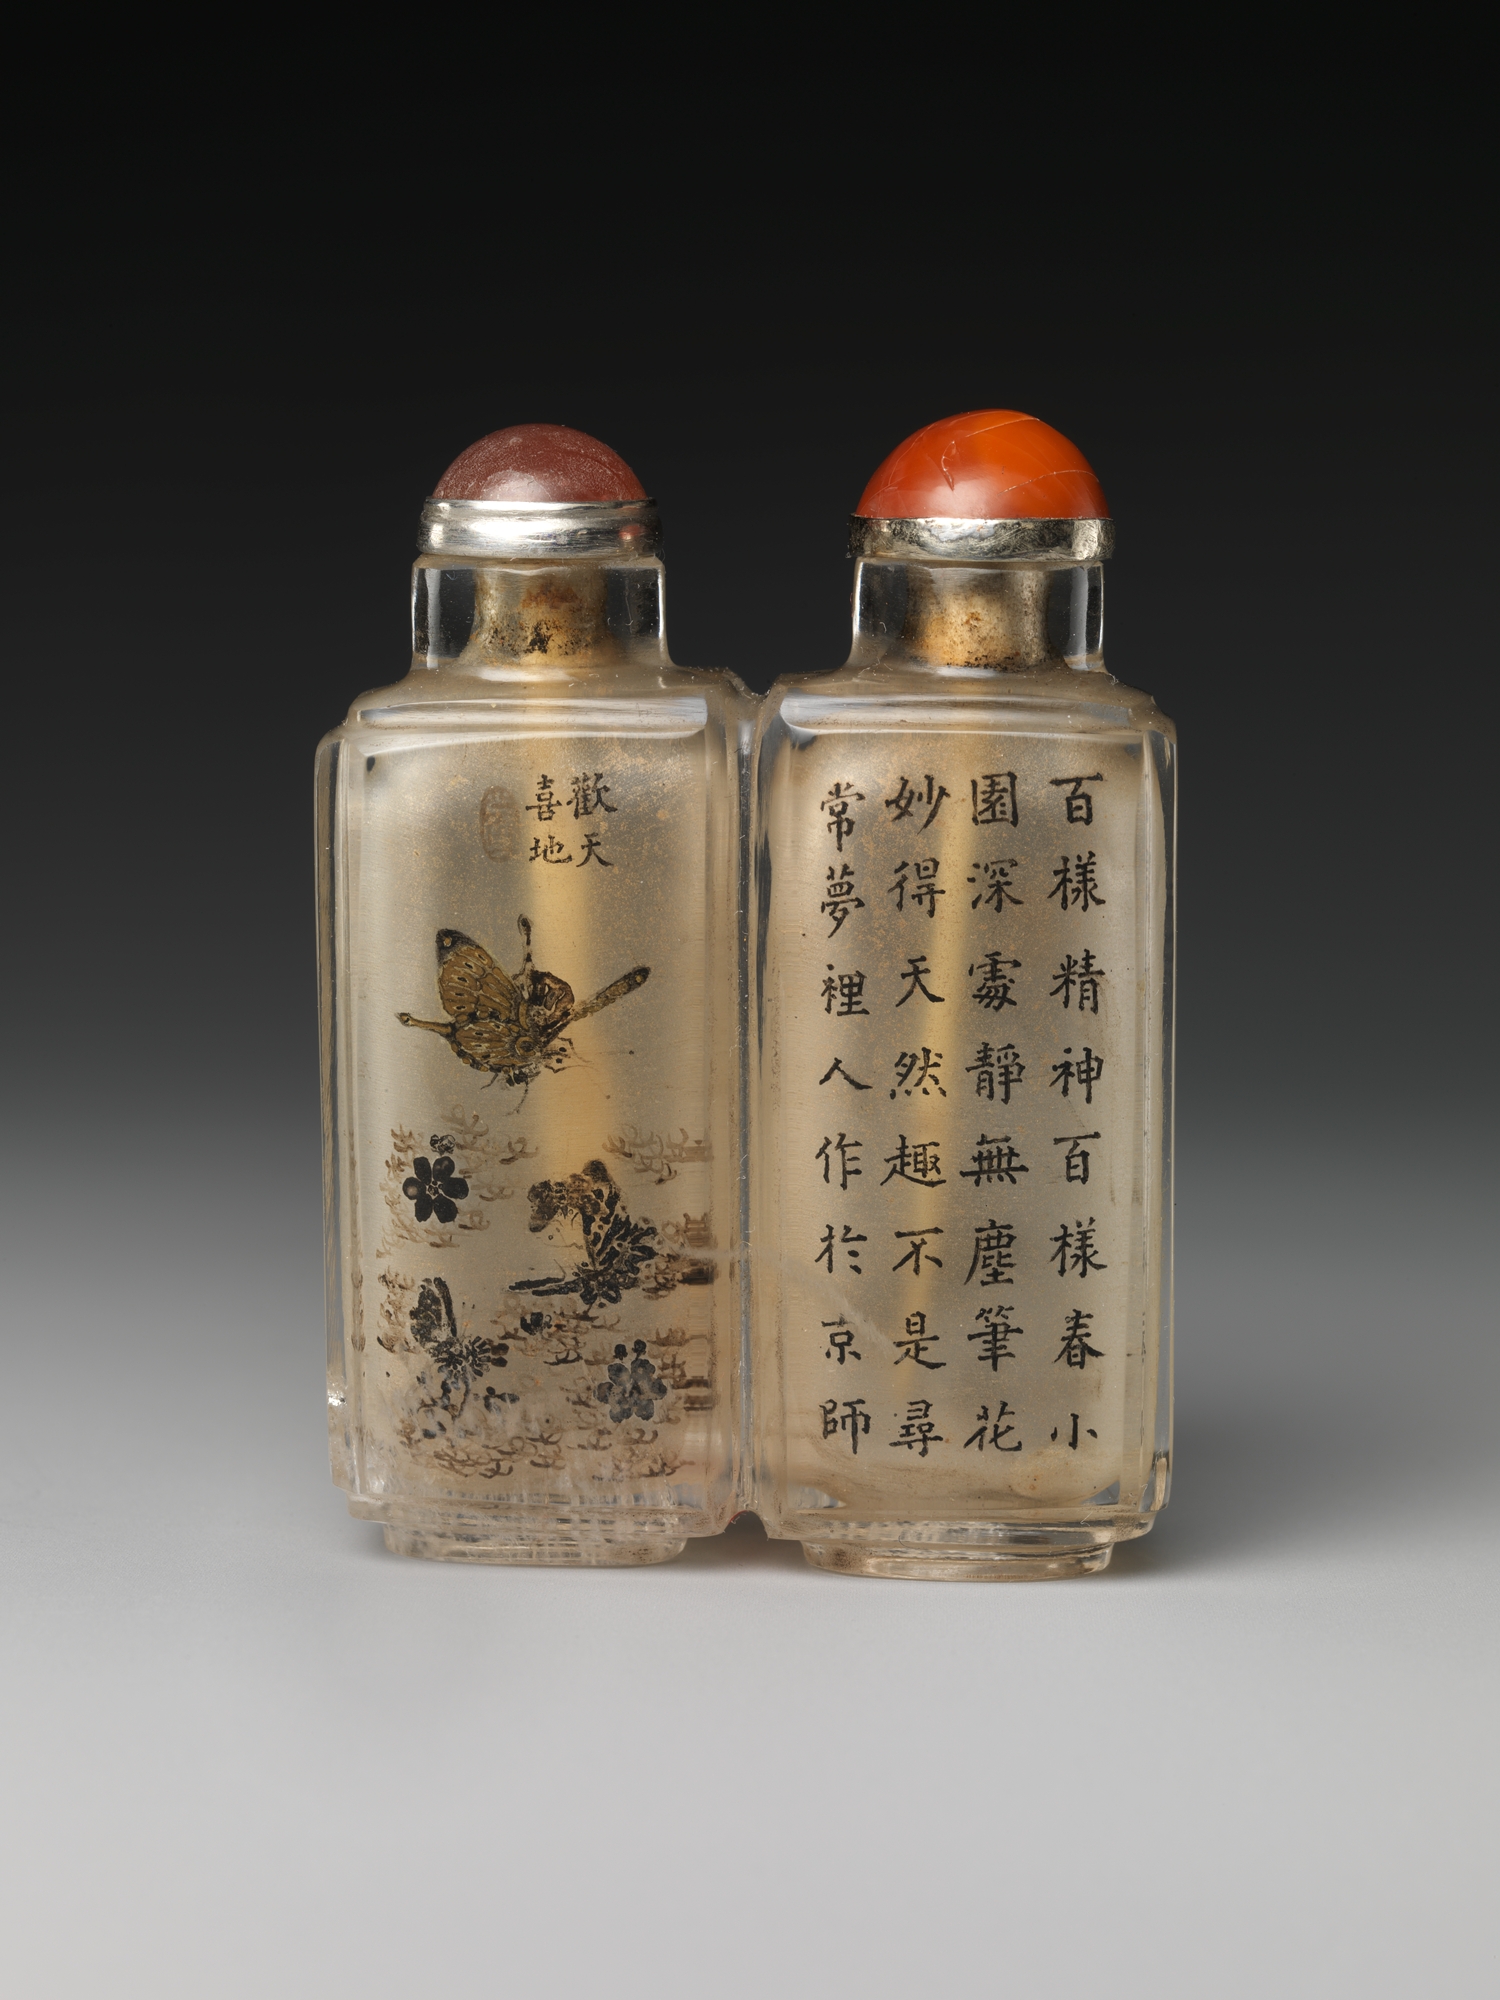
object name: double snuff bottle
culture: chinese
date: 1801-1900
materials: crystal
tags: butterflies